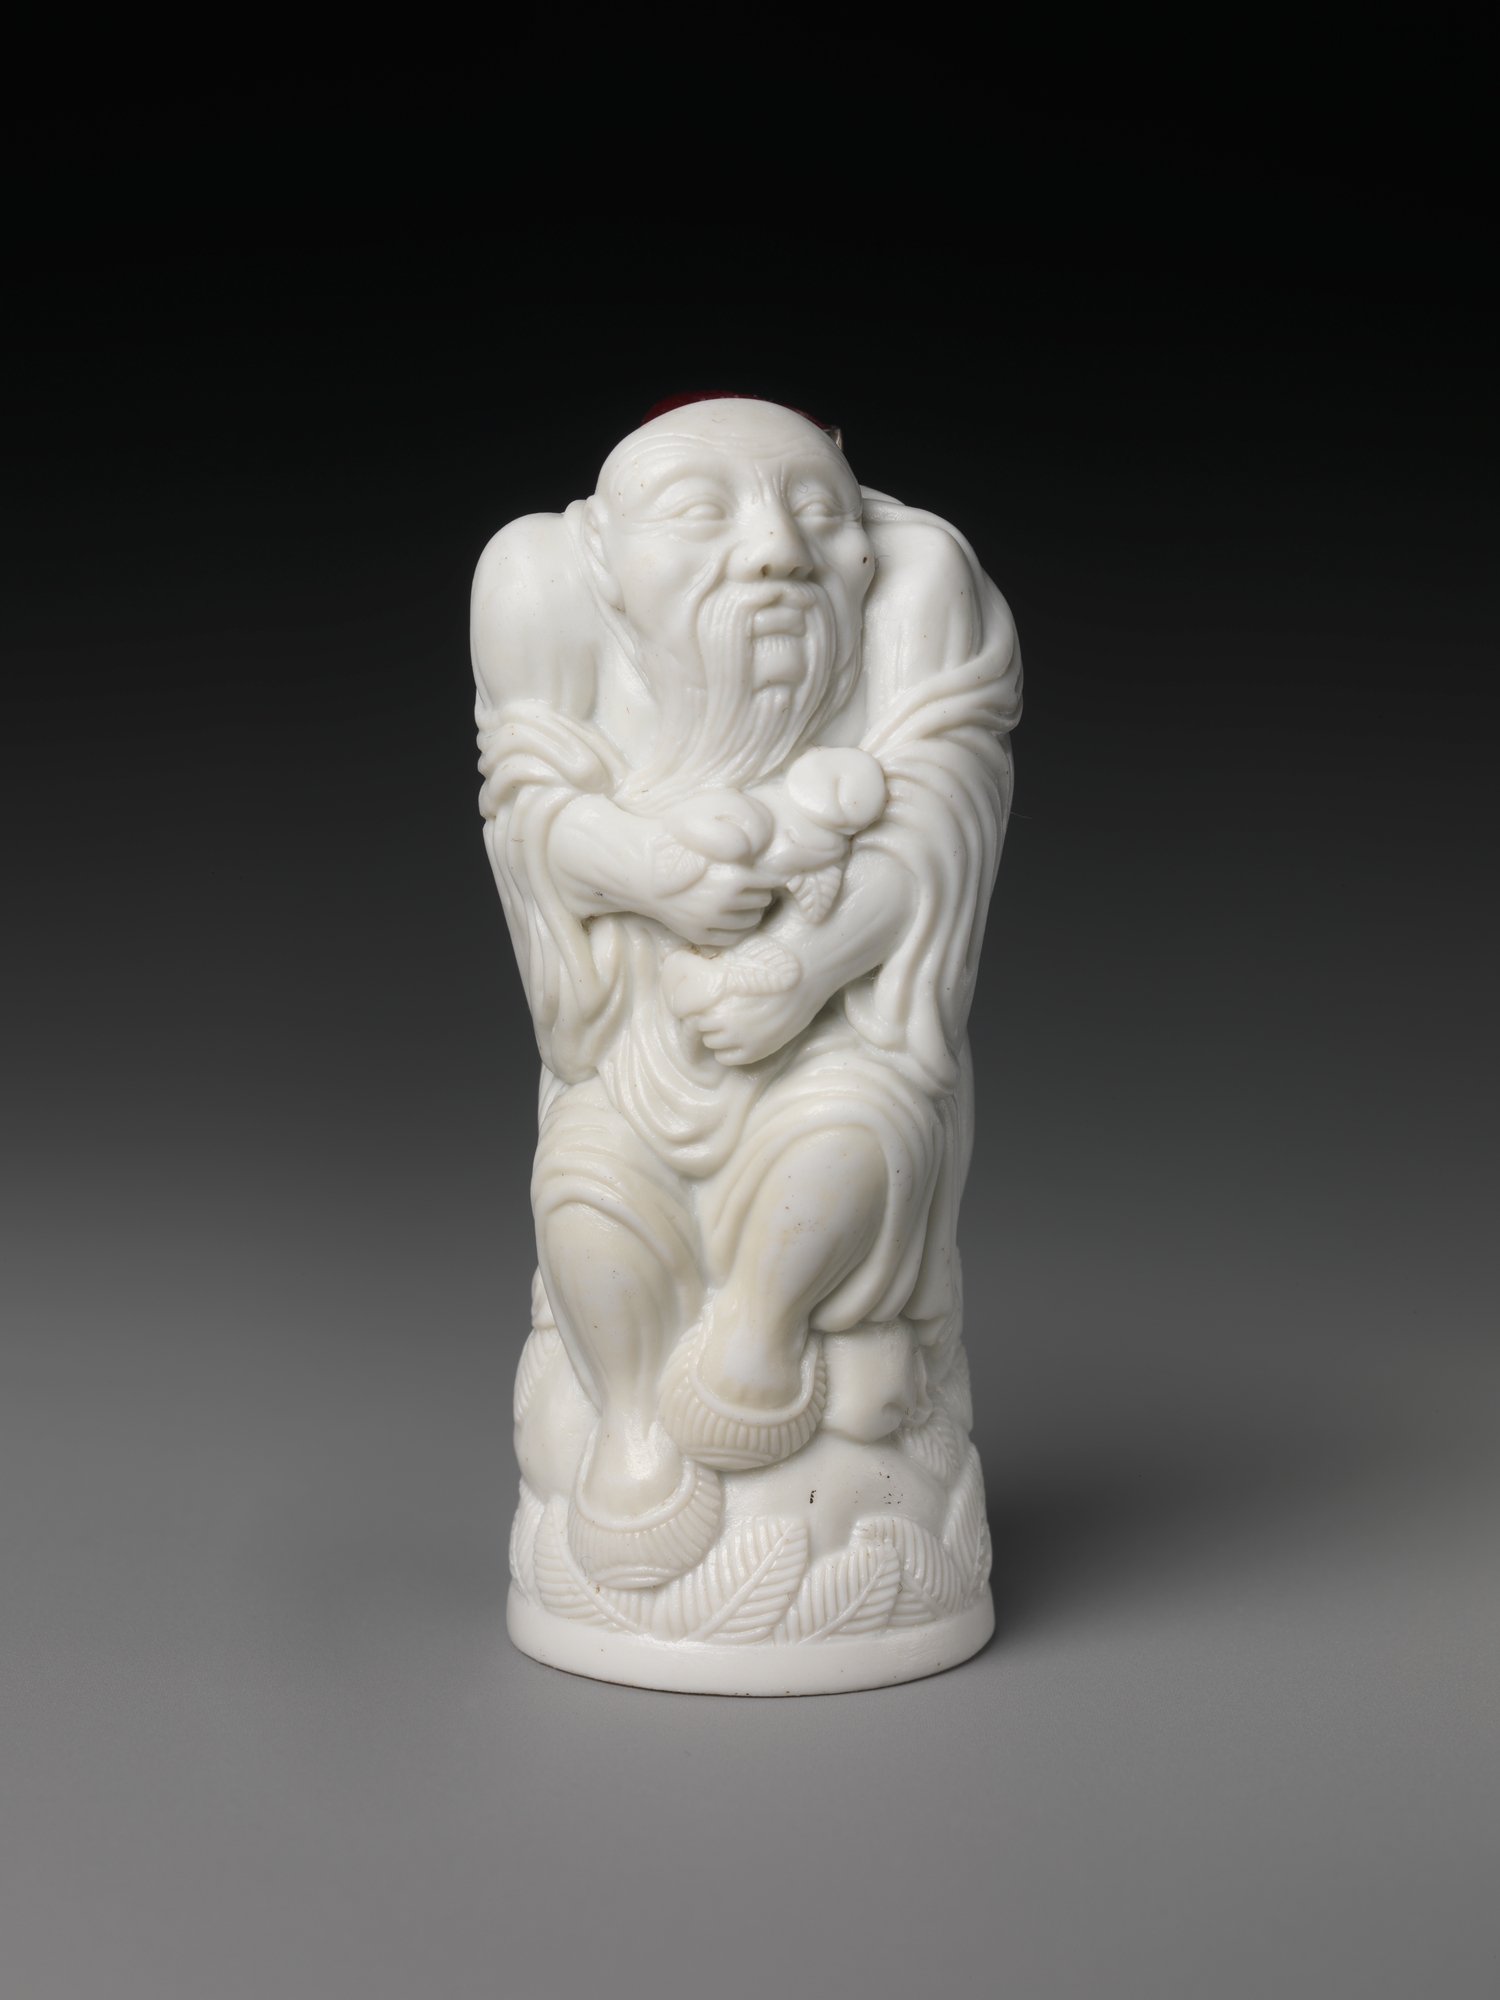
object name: snuff bottle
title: Snuff Bottle Depicting the God of Longevity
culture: chinese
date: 1801-1900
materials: biscuit, porcelain, gemstone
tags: men